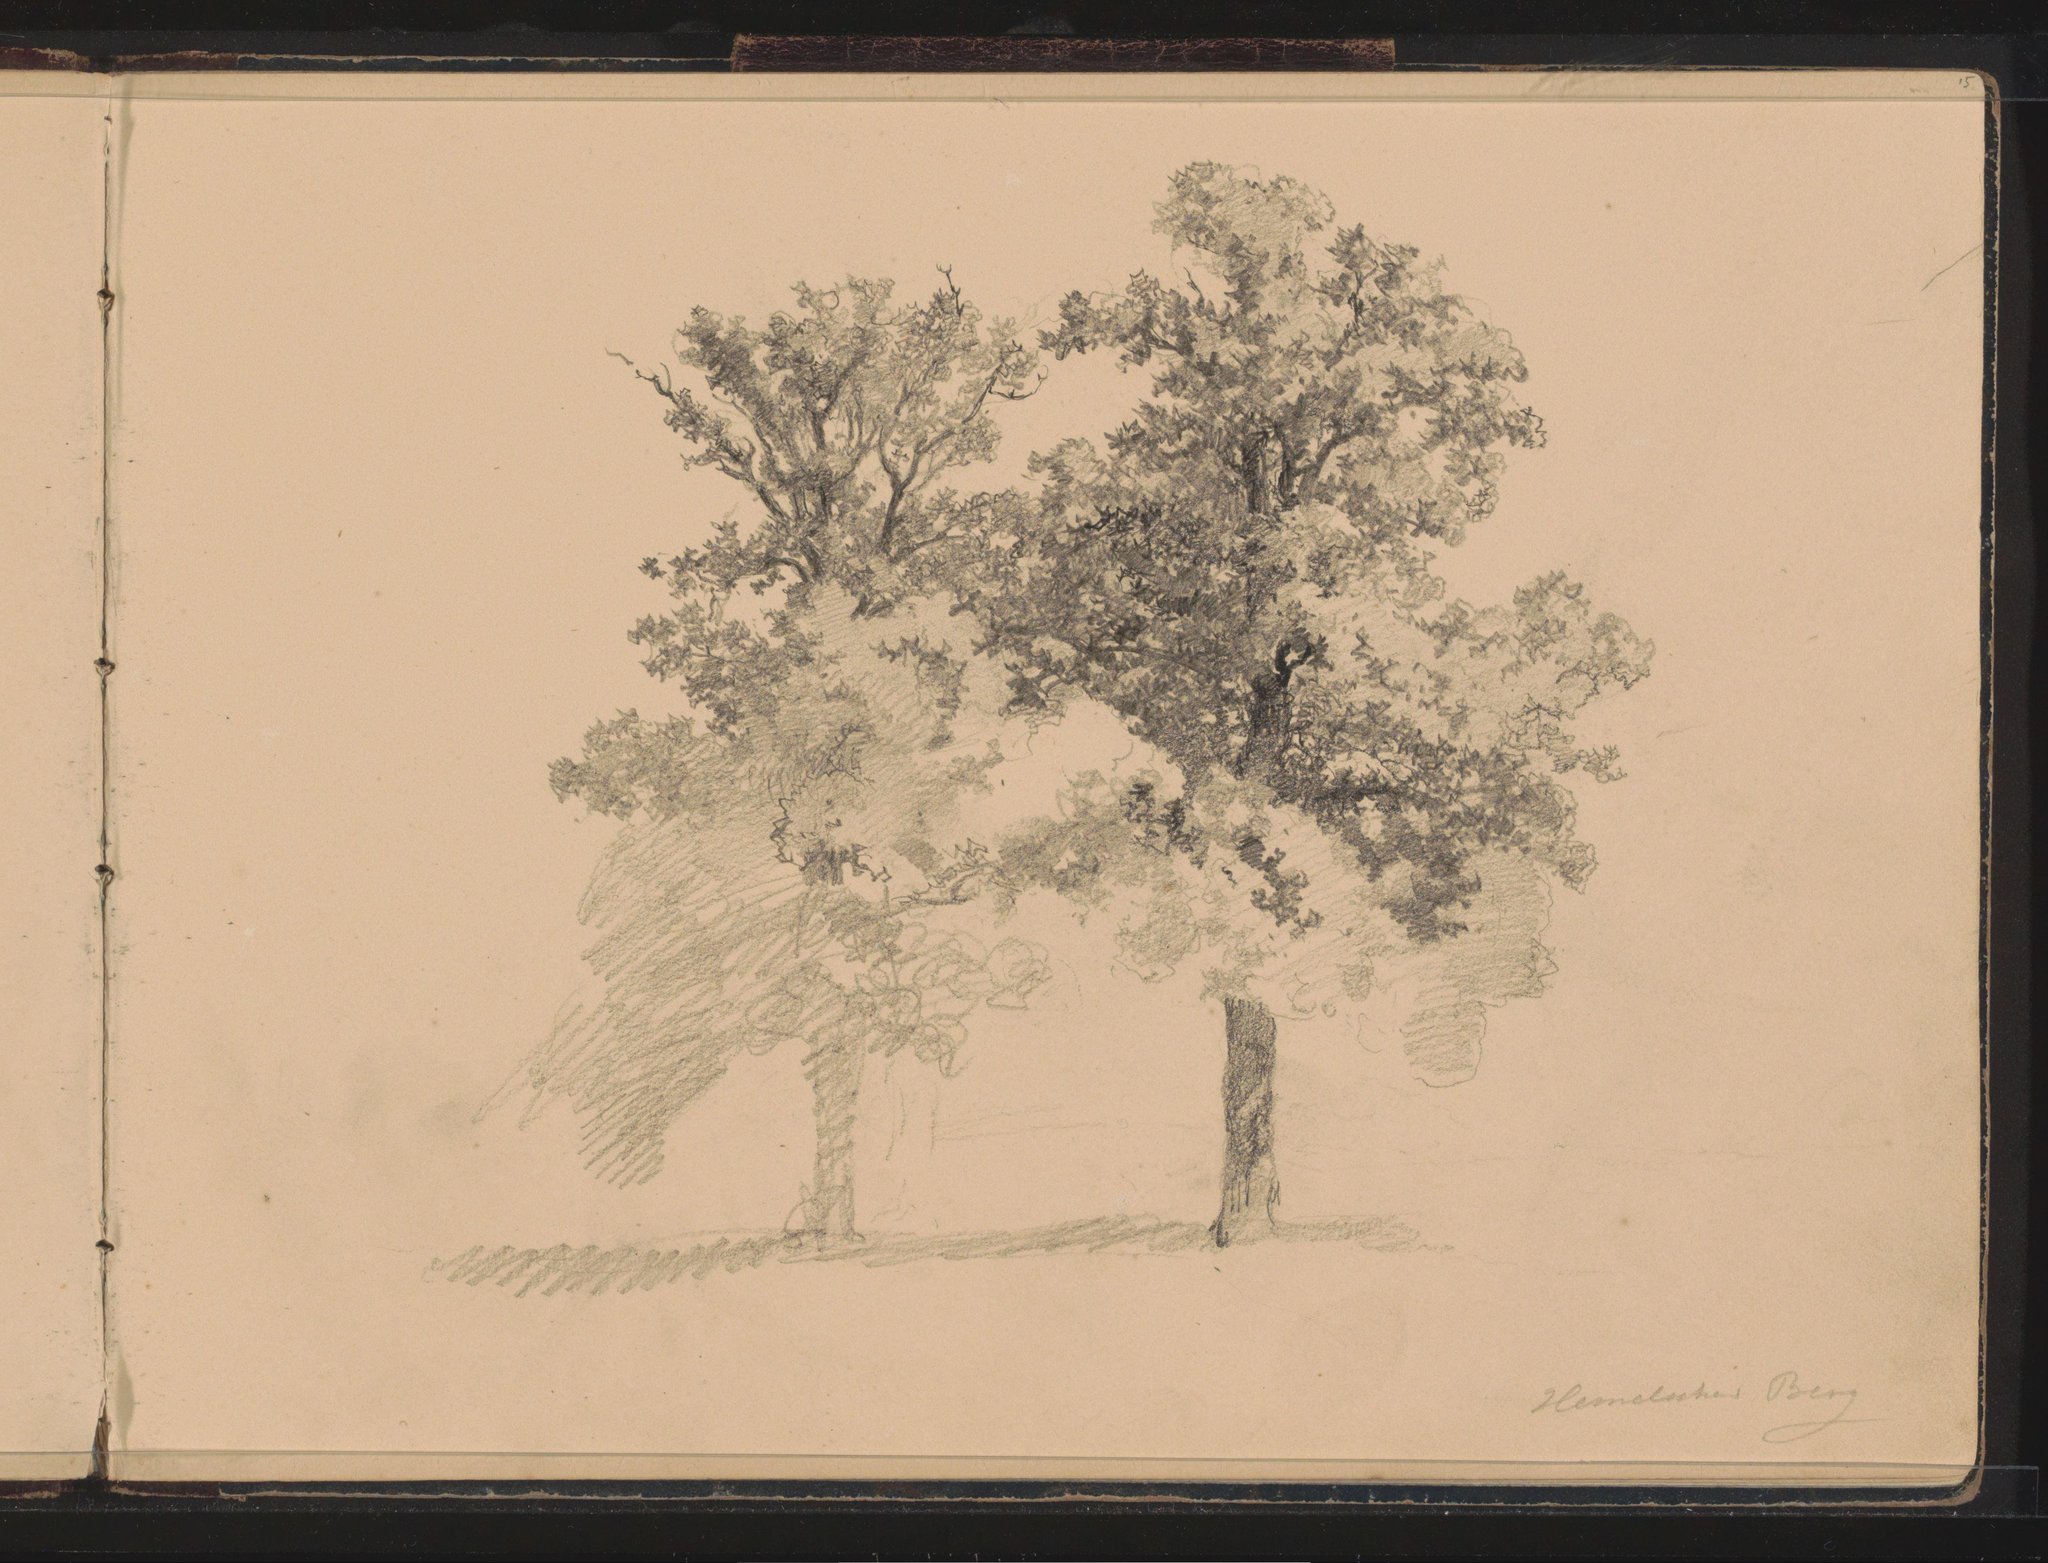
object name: sketchbook leaf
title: Bomen bij de Hemelschen Berg te Oosterbeek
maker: maria vos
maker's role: draughtsman, painter, print maker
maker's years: 1824-1906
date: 1864-1865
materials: paper, pencil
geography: oosterbeek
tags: trees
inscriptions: annotation: ‘Hemelschen Berg’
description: Blad 15 recto uit een schetsboek met 44 bladen.